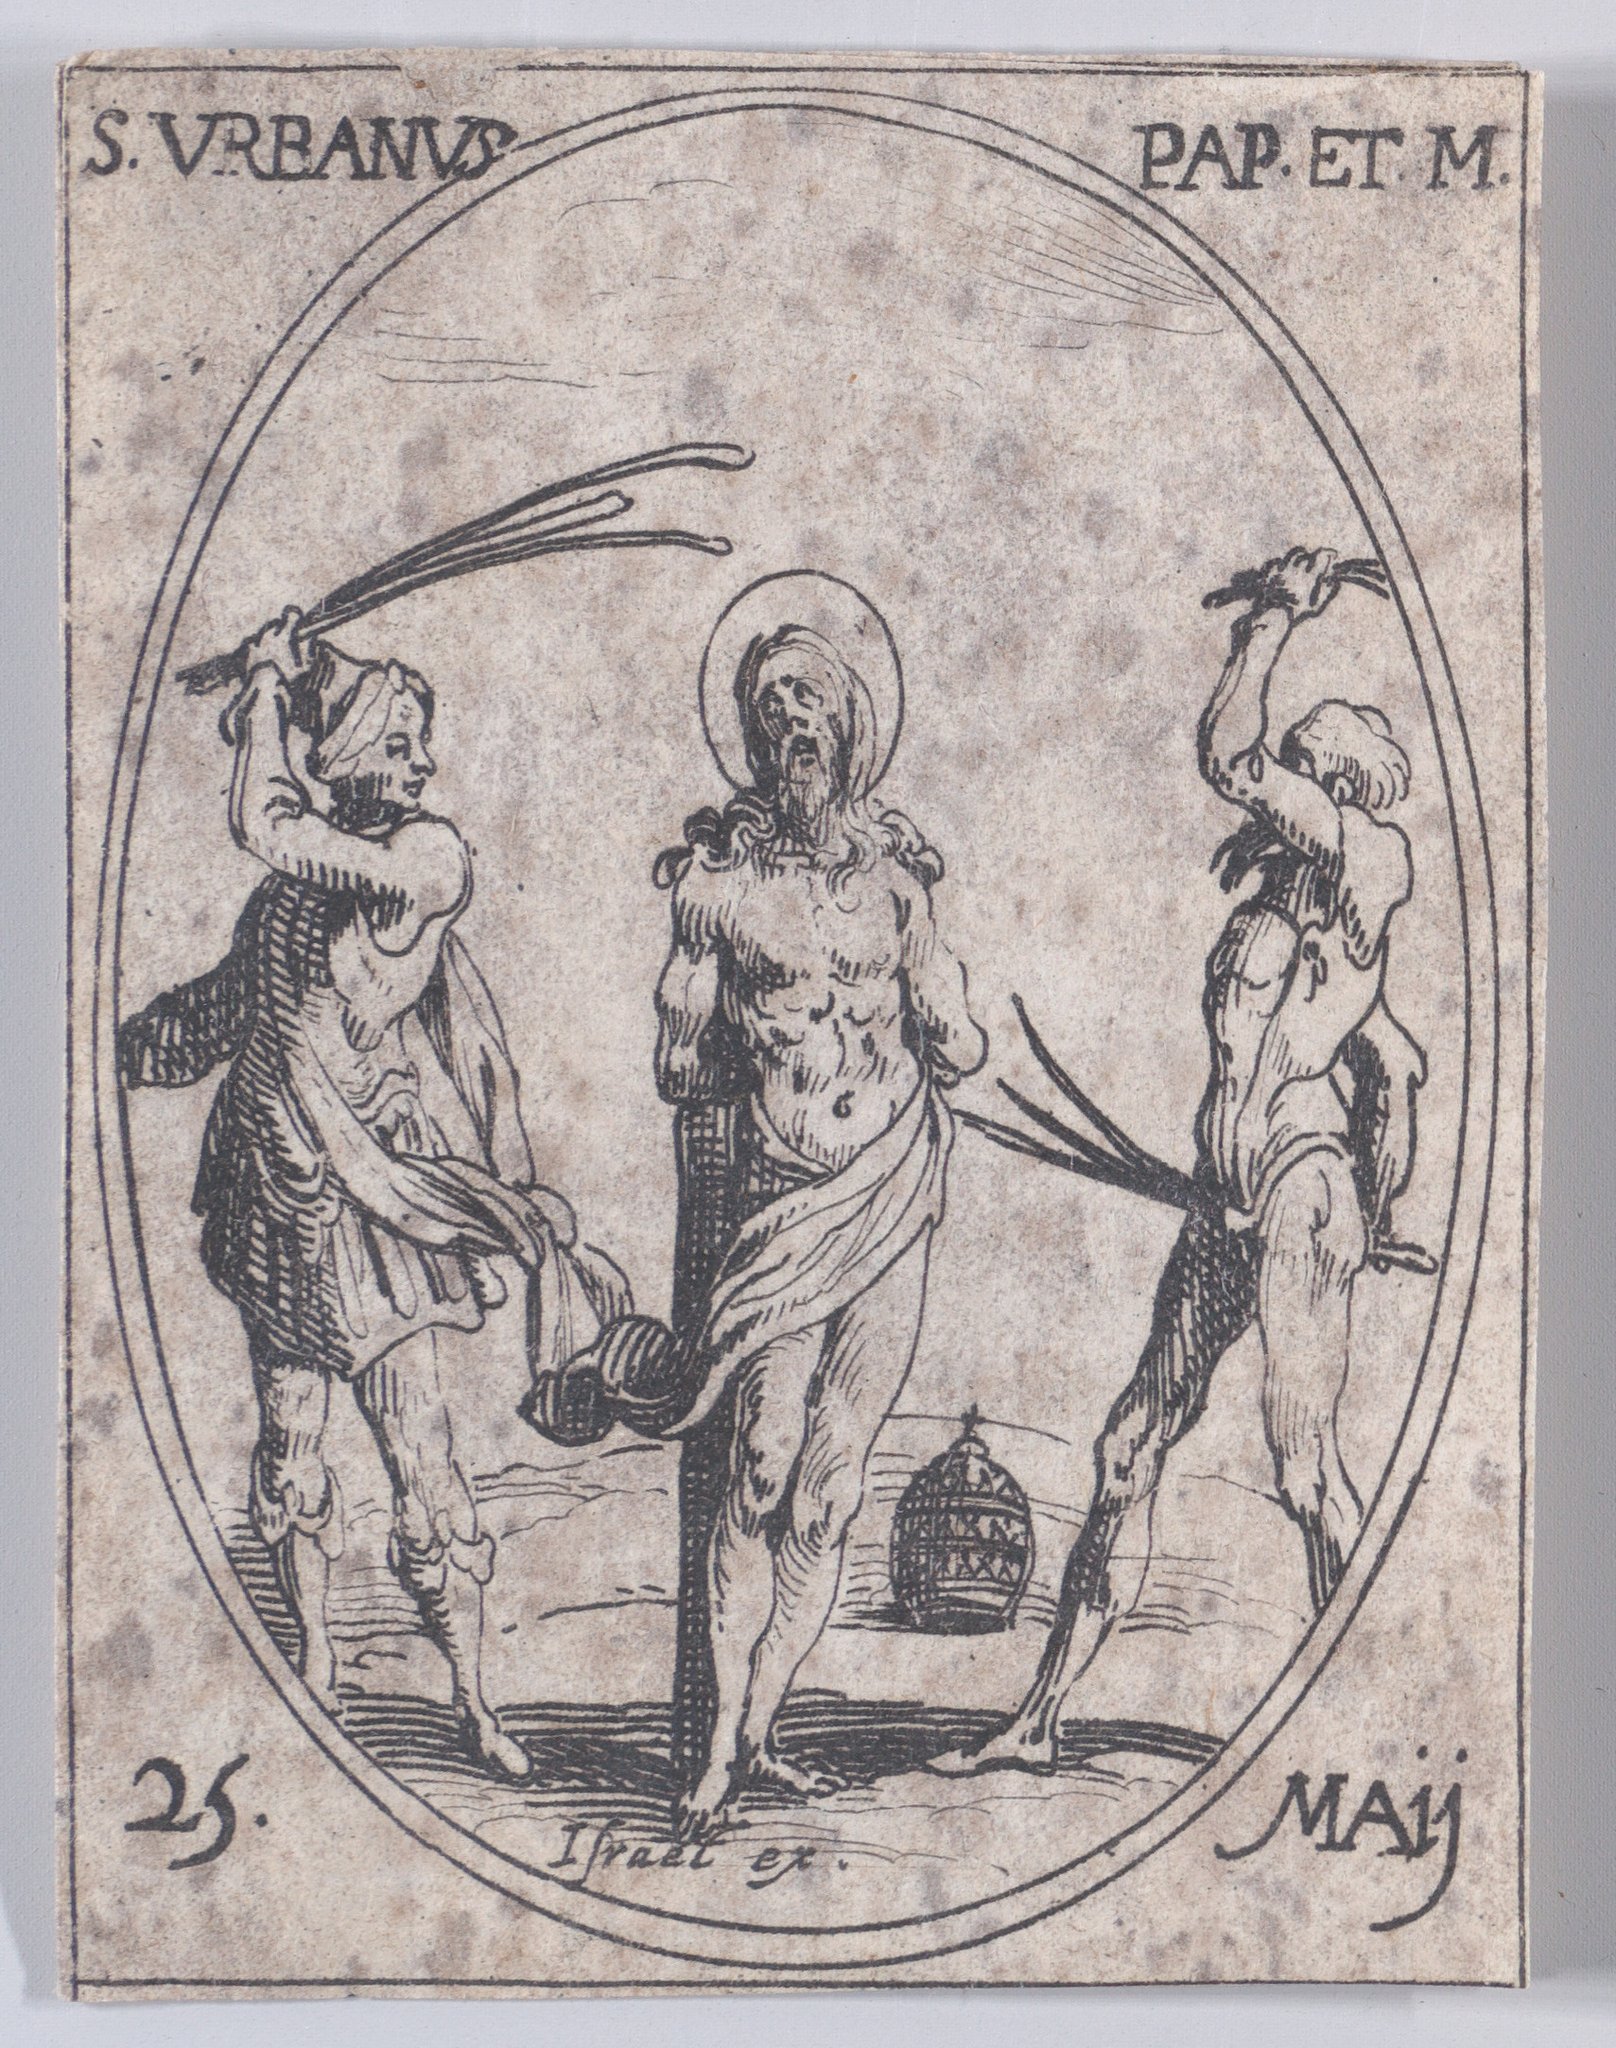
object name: print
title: S. Urbain, pape et martyr (St. Urban, Pope and Martyr), May 25th, from "Les Images De Tous Les Saincts et Saintes de L'Année" (Images of All of the Saints and Religious Events of the Year)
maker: jacques callot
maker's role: artist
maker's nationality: french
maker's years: 1592-1635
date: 1636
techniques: etching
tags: men,saints